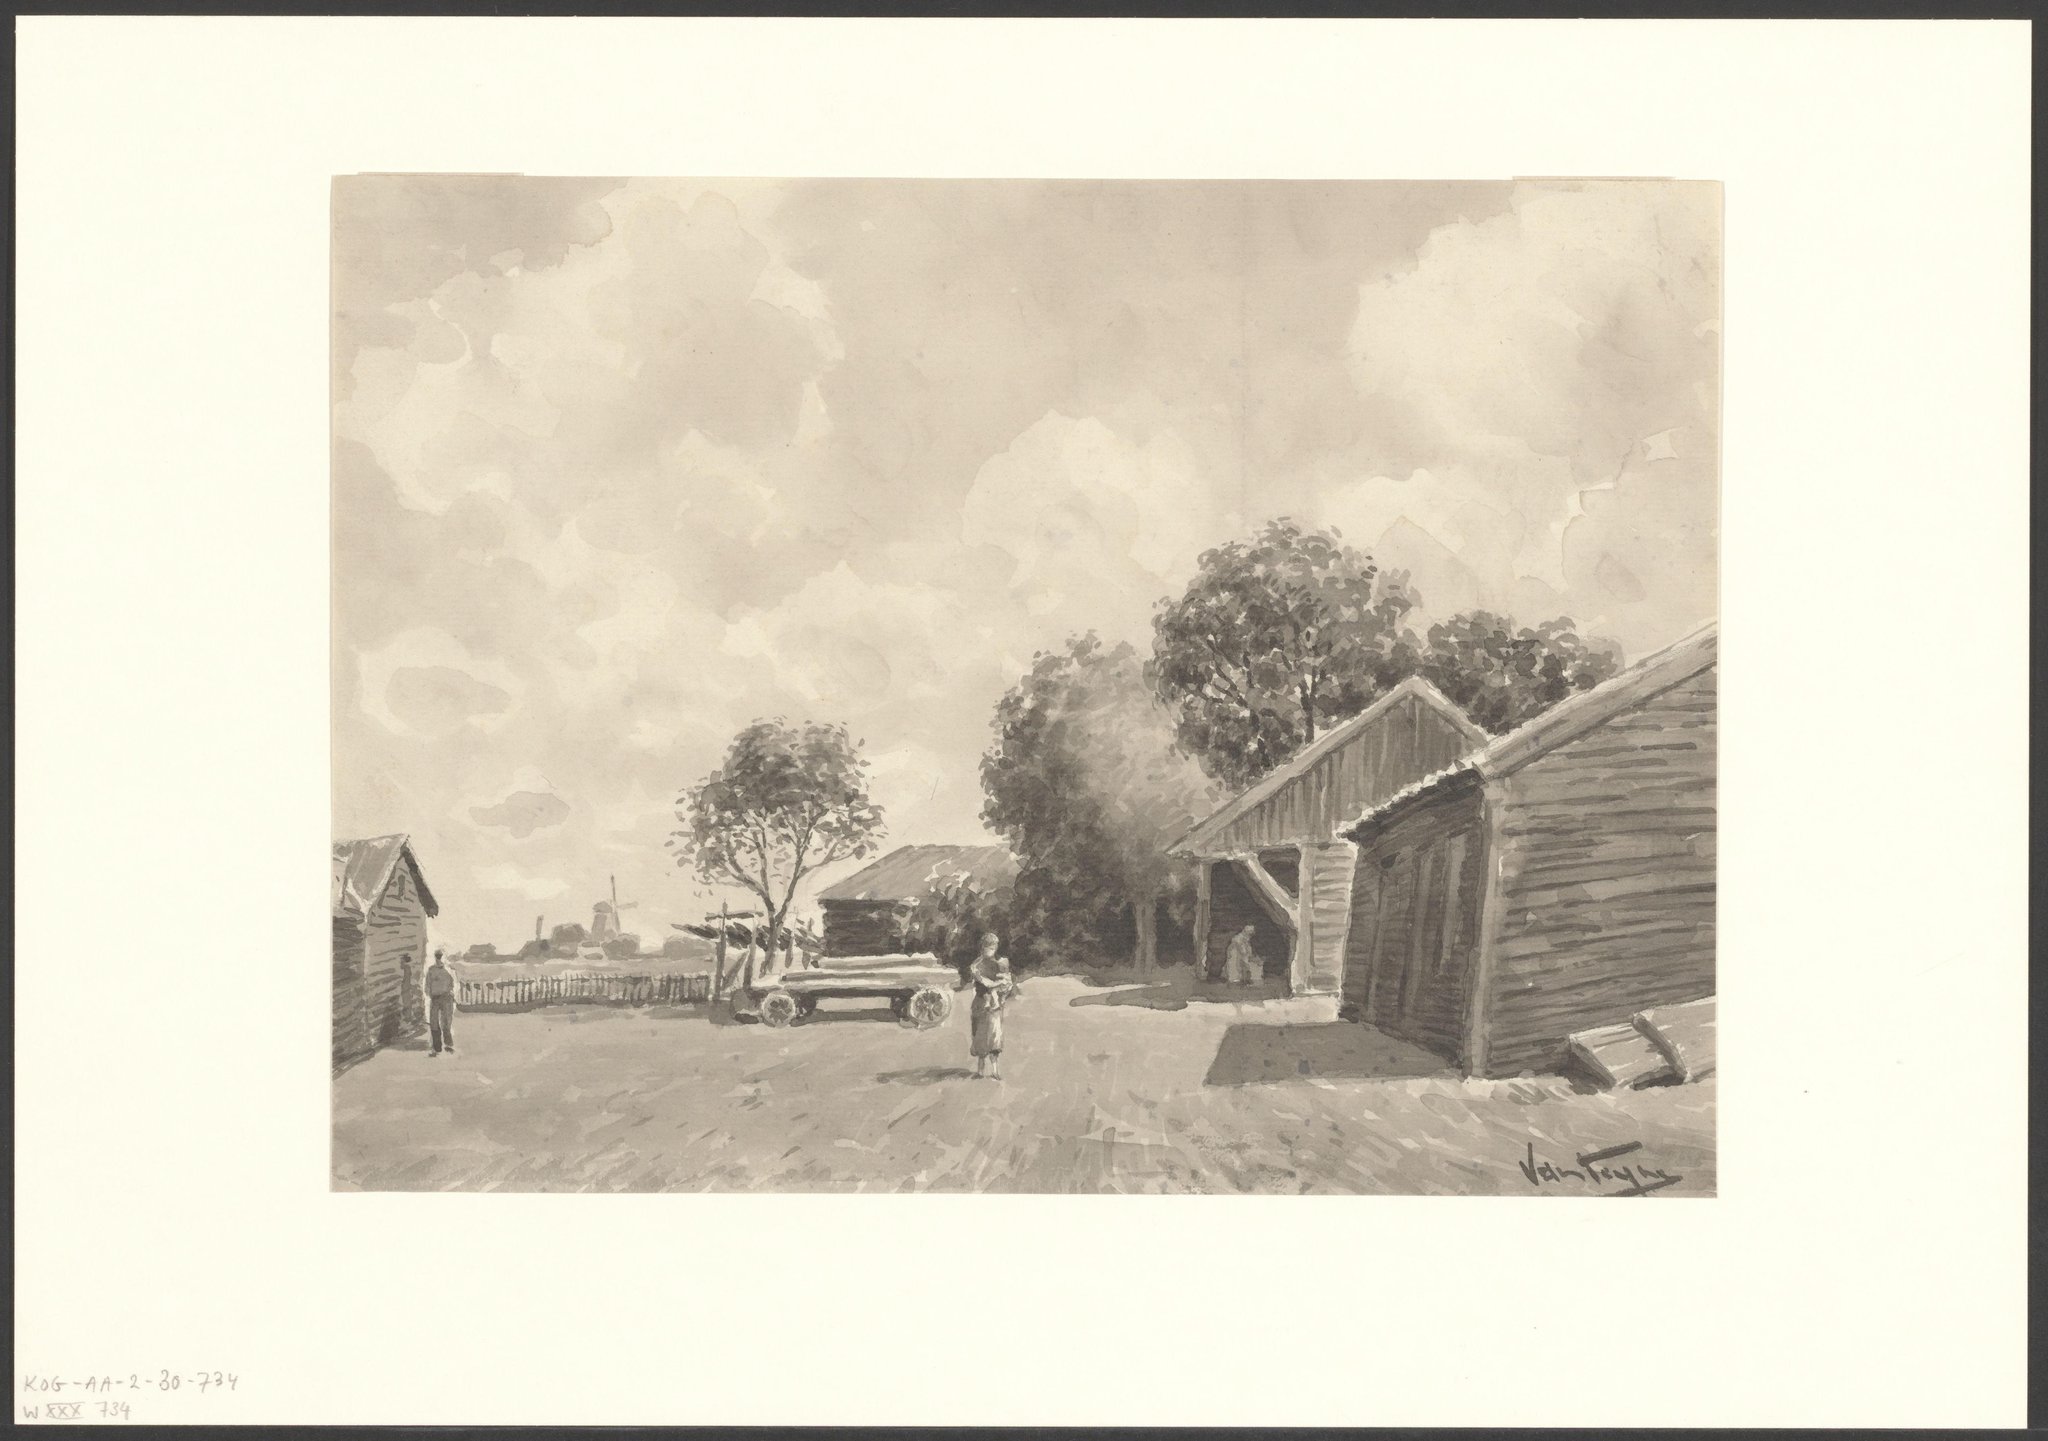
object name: drawing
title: Gezicht op het Terrein van Roos aan de Kostverlorenvaart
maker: anthonie van teijn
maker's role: draughtsman, painter, print maker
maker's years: 1863-1943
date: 1907-1927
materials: ink, paper, pencil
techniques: brush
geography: amsterdam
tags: city-view in general; 'veduta', windmill in landscape, farm or solitary house in landscape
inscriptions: number: ‘11’, collector's mark: Lugt 800a, signature: ‘VanTeyne’, inscription: ‘"Het terrein van (...) Juli 1927. / vEck’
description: Tekening binnen de Atlas Van Eck ingedeeld op wijknummer 30.